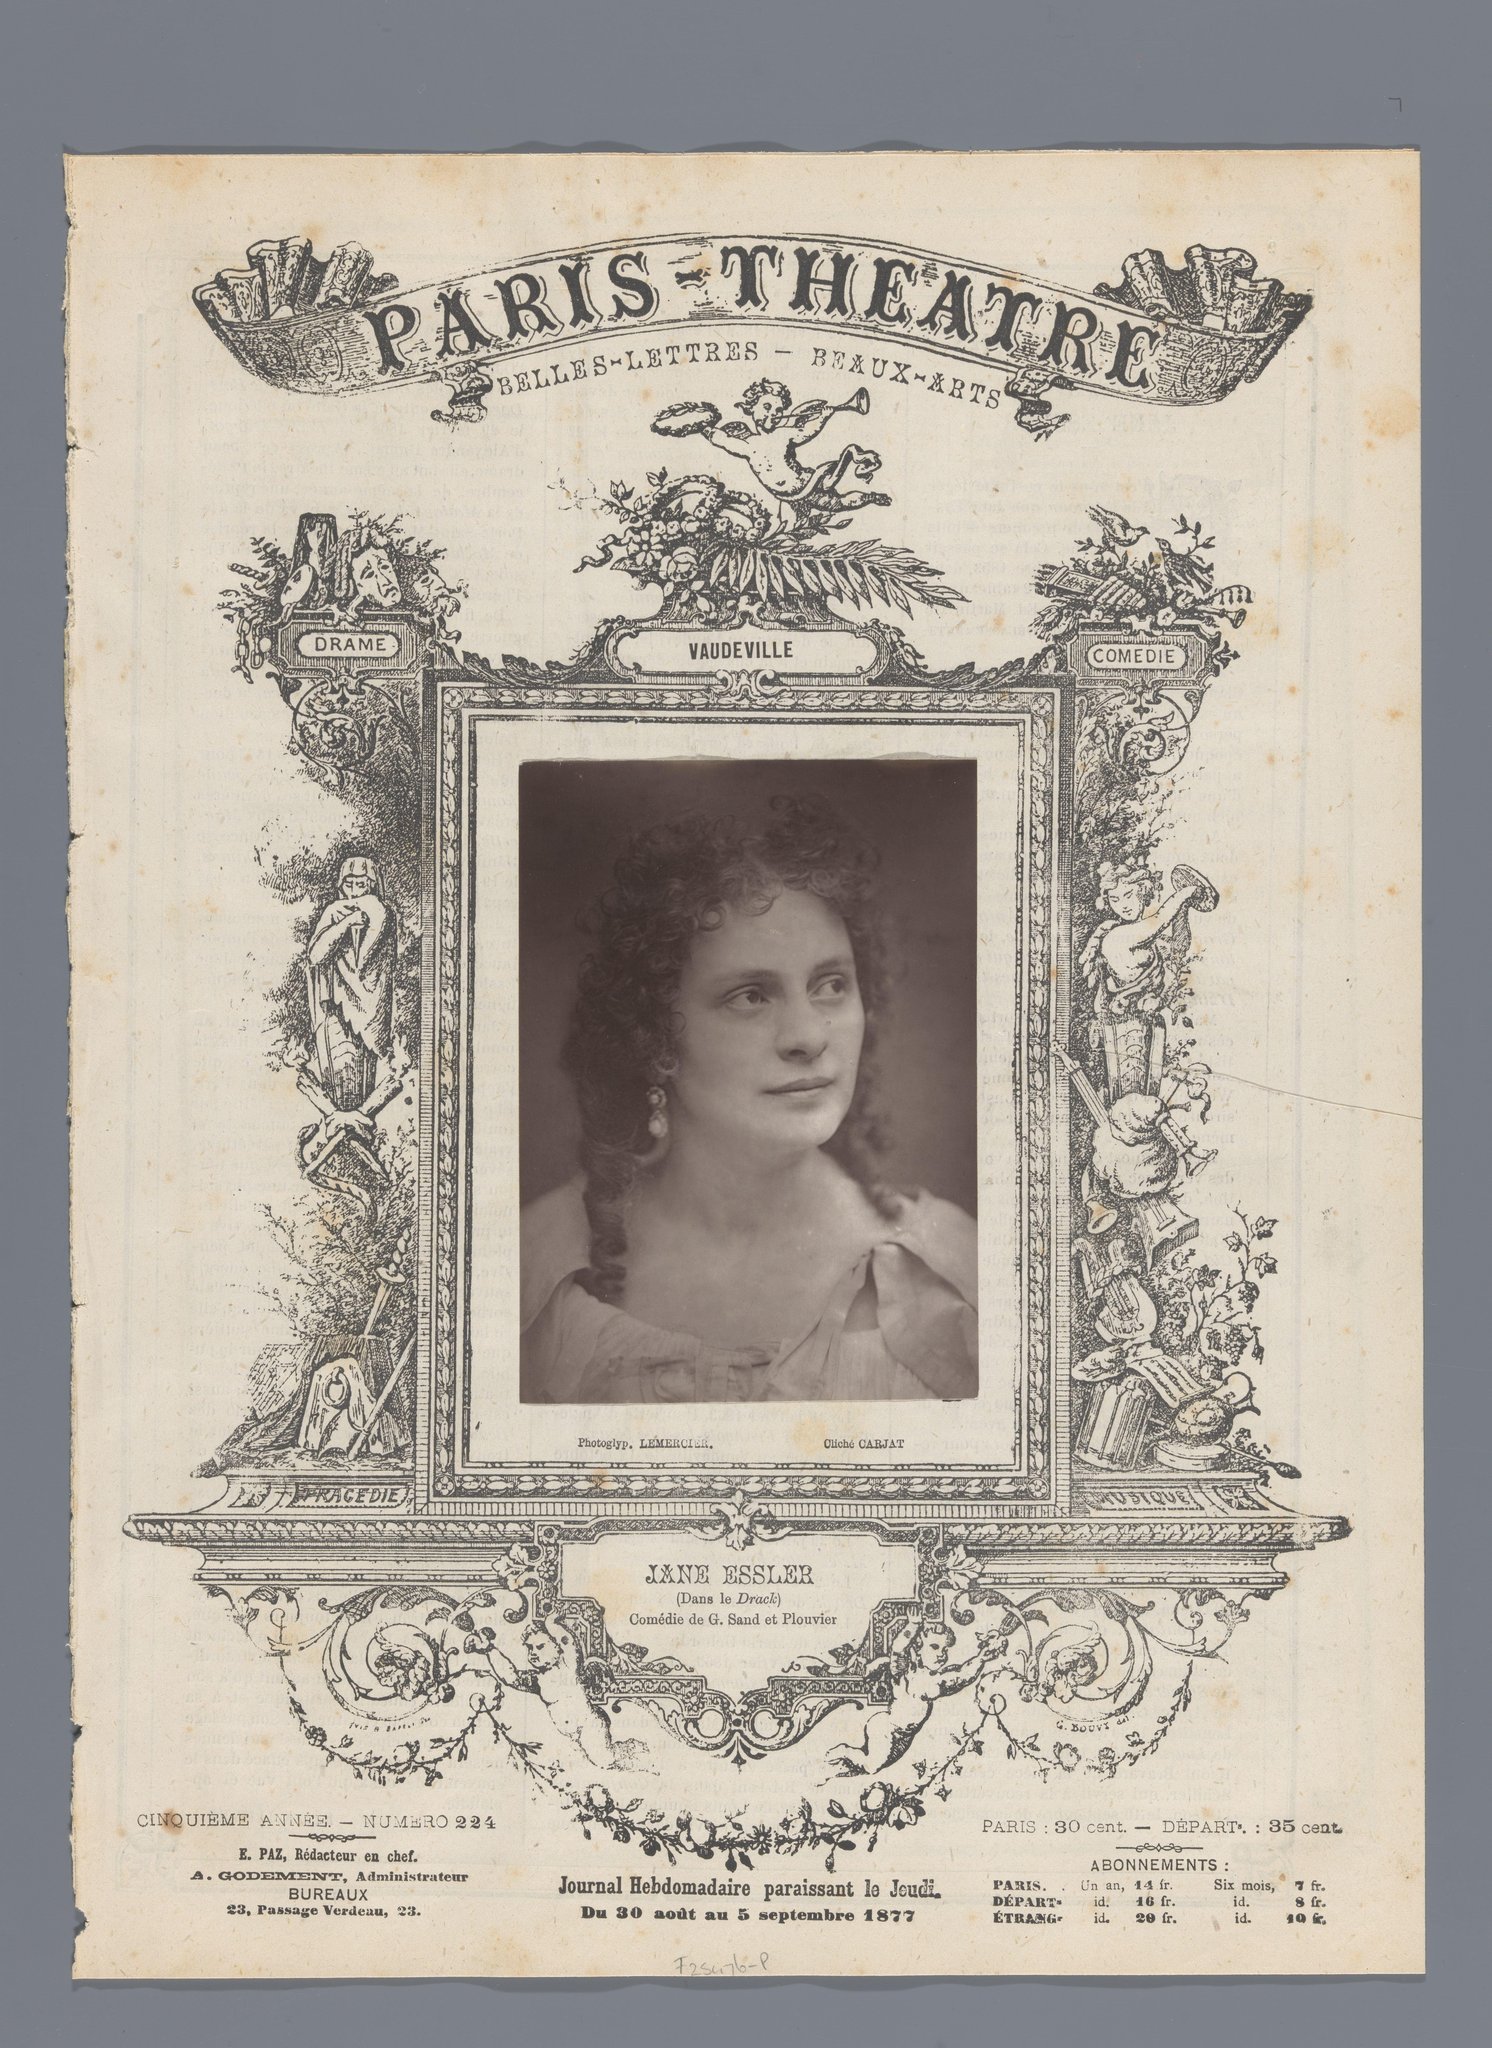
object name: photomechanical print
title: Jane Essler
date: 1872-1879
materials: paper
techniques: woodburytype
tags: paris, historical persons - bb - woman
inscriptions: inscription: ‘(Dans le Drack) Comedie de G. Sand et Plouvier’